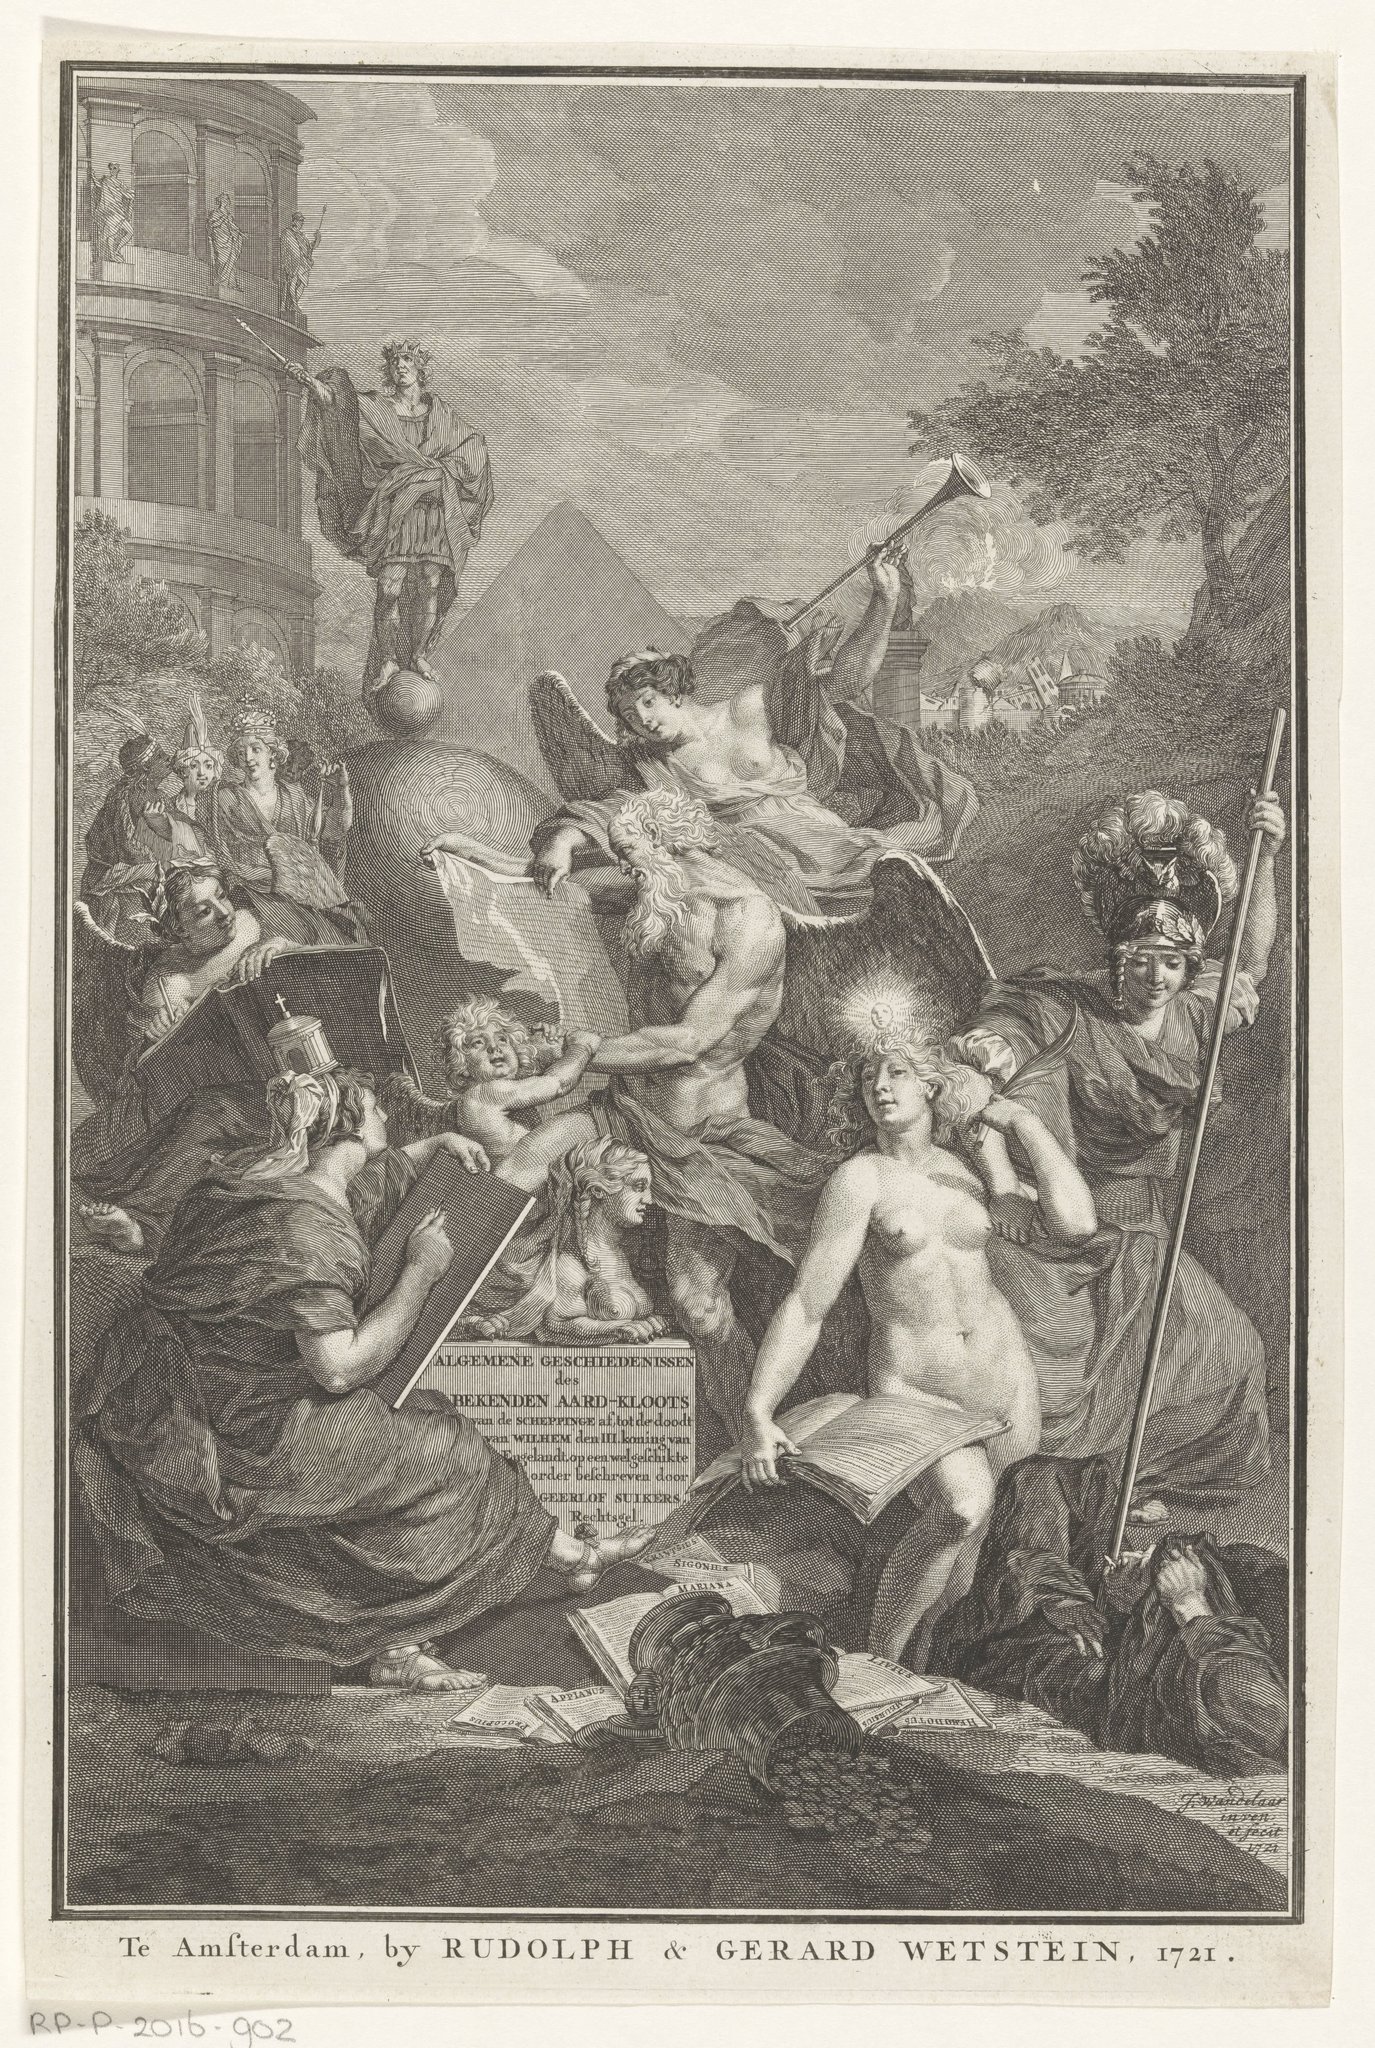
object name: titelblad, titelpagina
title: Allegorische figuren rond een sfinx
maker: jan wandelaar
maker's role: draughtsman, print maker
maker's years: 1690-1759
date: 1721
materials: paper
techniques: engraving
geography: amsterdam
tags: sphinx (lion/woman); 'sfinge' (ripa), (story of) minerva (pallas, athena), truth; 'verità' (ripa), 'historia'; 'historia' (ripa), fame; 'fama', 'fama buona', 'fama chiara' (ripa), father time, man with wings and scythe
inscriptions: collector's mark: Lugt 2228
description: Menigte allegorische figuren rond een sfinx op een sokkel. Links Geschiedenis en een schrijvende vrouwelijke personificatie gekroond met een toren. Vader Tijd ontrolt een papier, in de lucht de Faam. Rechts de Waarheid: een naakte vrouw met een boek en de zon op haar hoofd. Achter haar Minerva, die met haar lans een duivelse figuur de aarde in duwt.